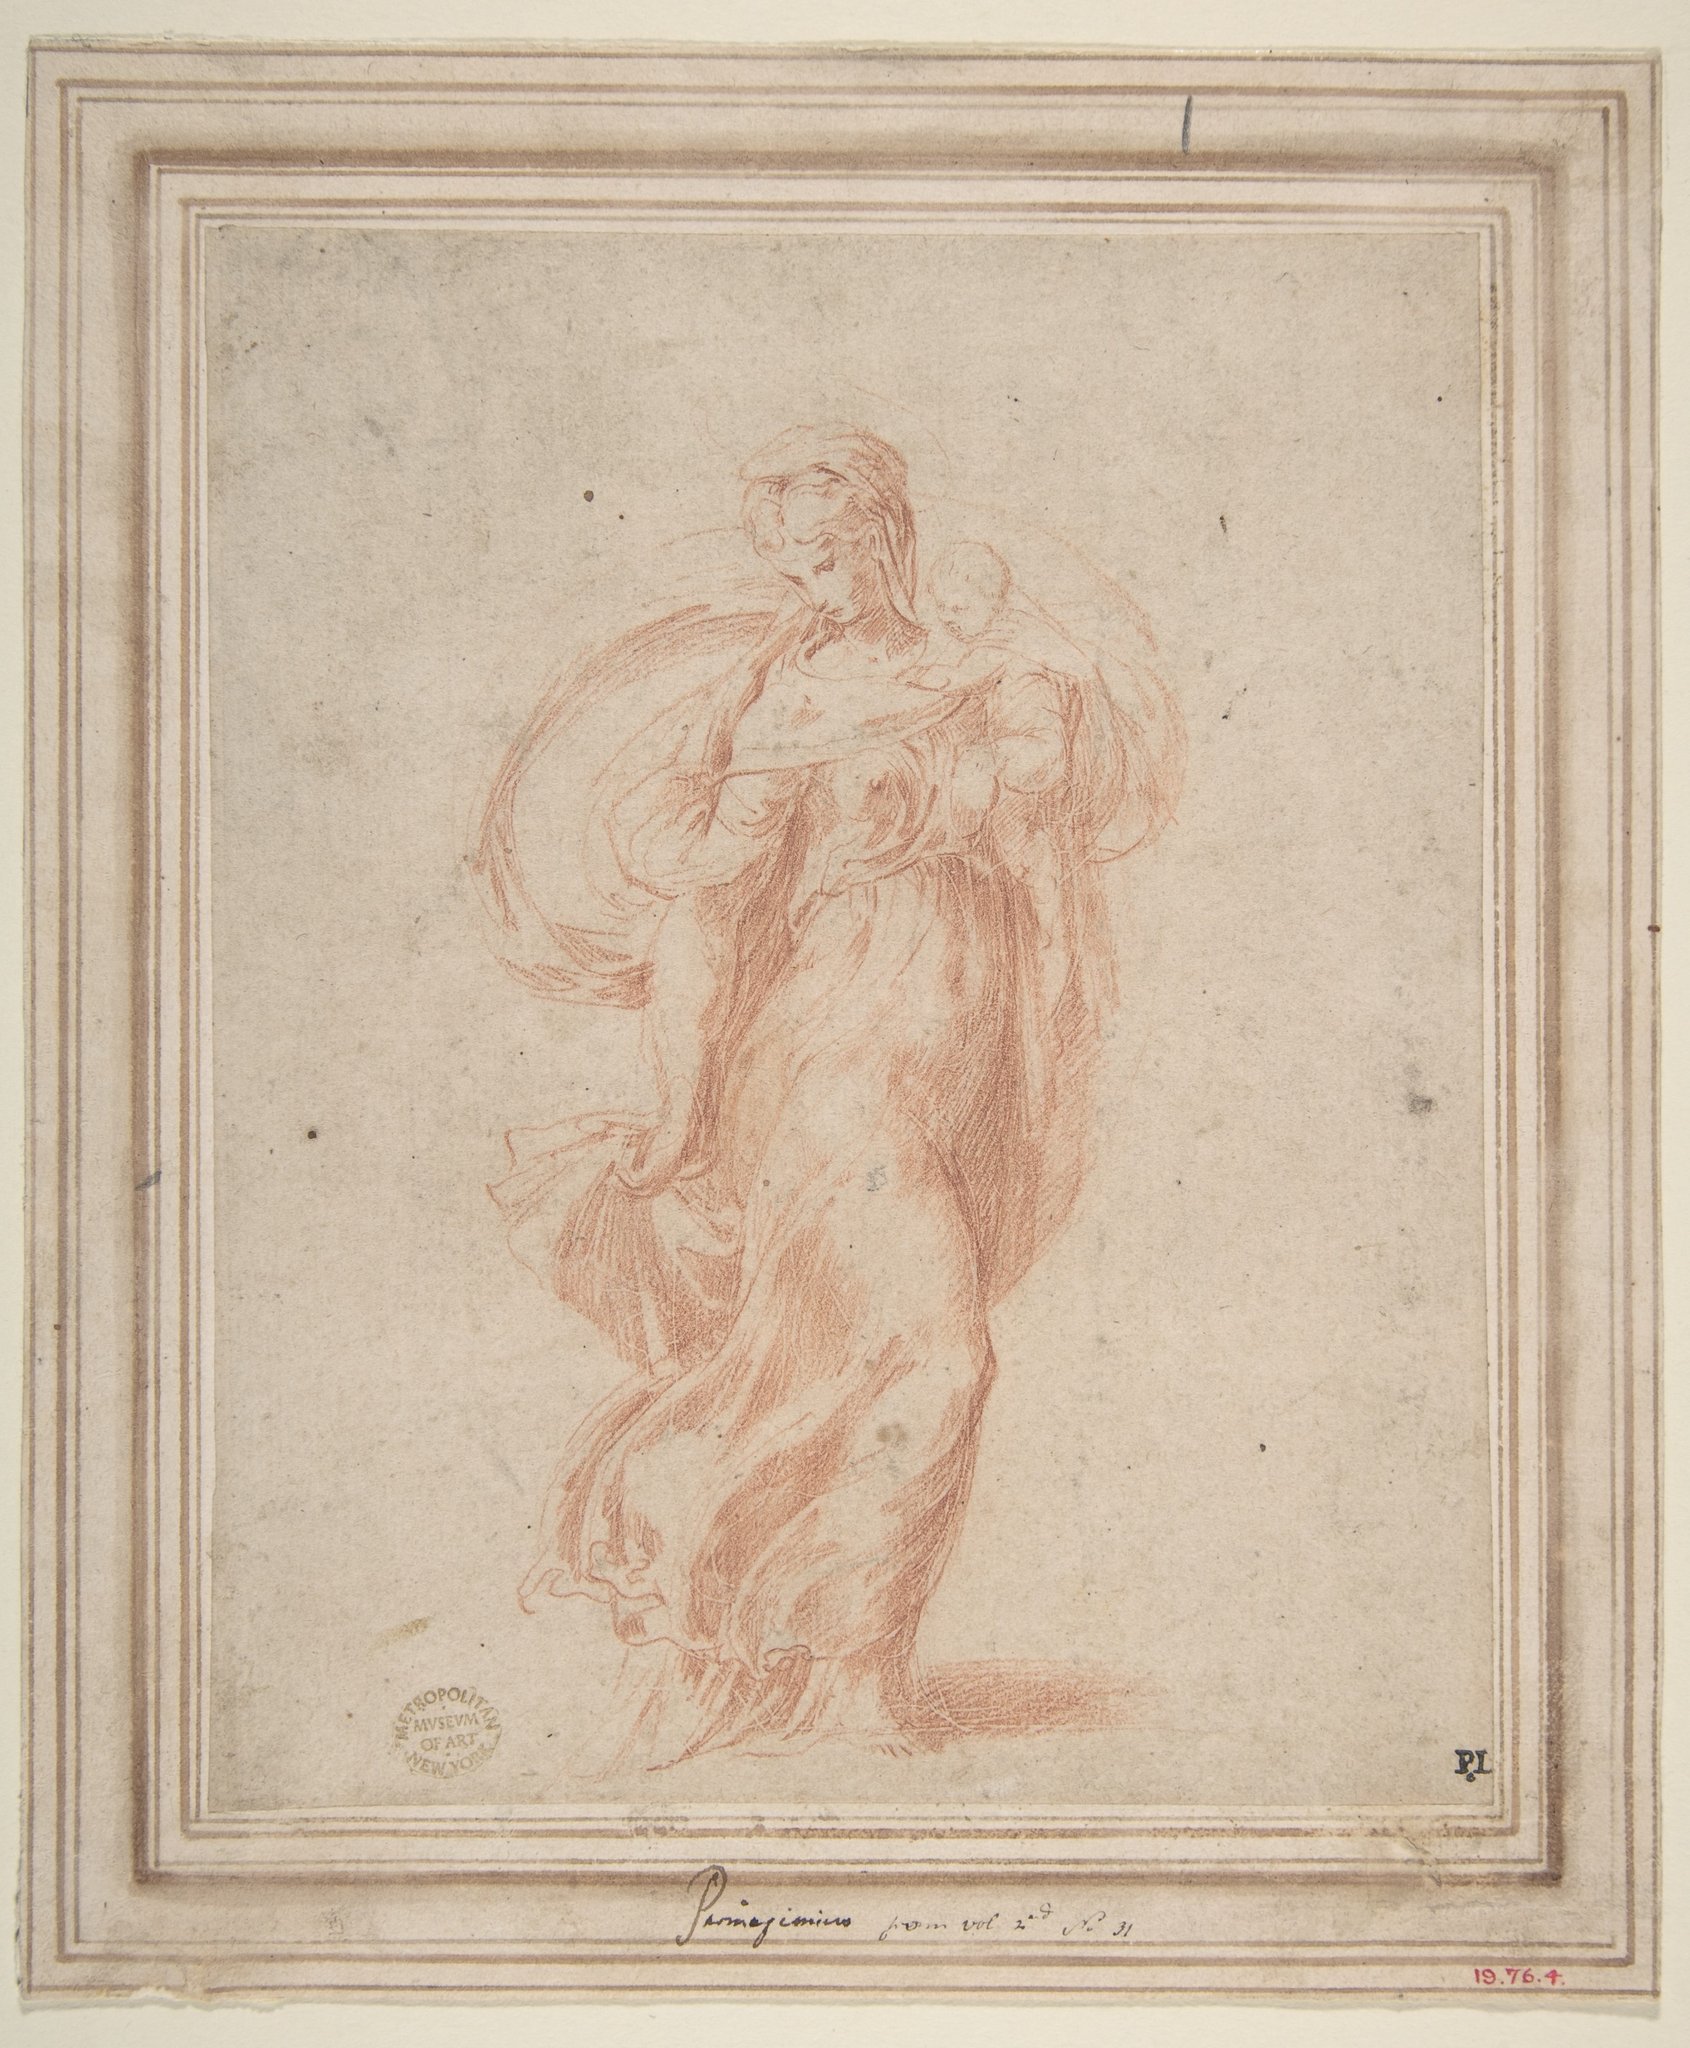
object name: drawing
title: The Virgin Walking to the Right Carrying the Christ Child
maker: parmigianino (girolamo francesco maria mazzola)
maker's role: artist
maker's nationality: italian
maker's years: 1503-1540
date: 1503-1540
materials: chalk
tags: madonna and child